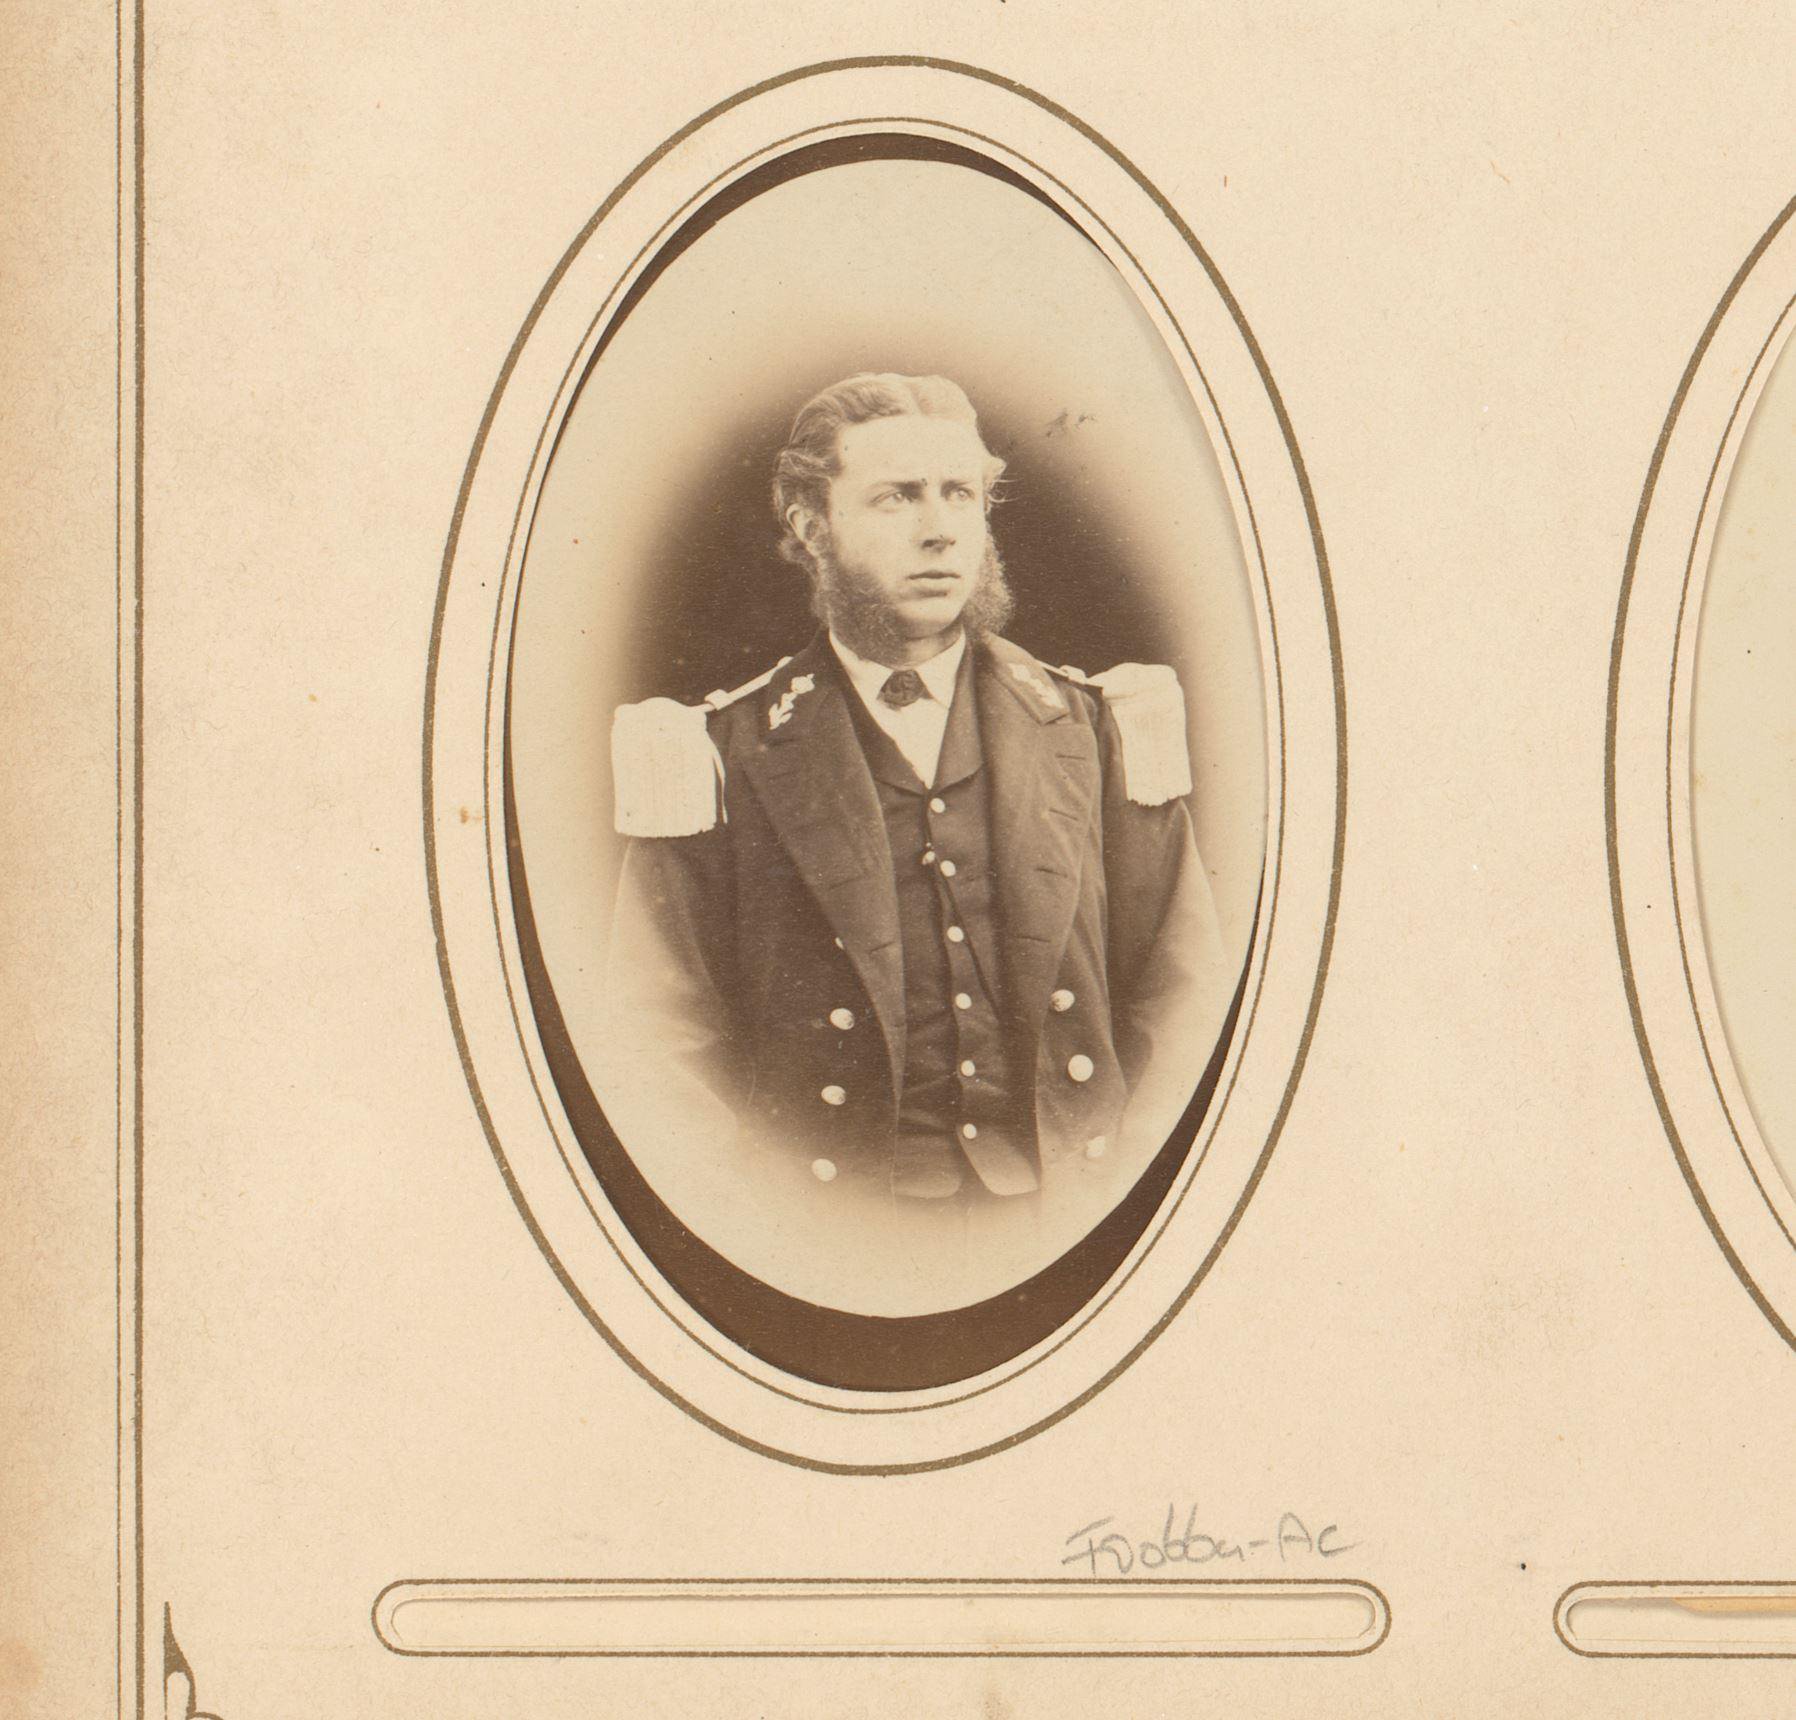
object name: album leaf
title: Portret van een man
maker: heinrich steinhauer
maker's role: fotograaf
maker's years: 1838-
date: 1869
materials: cardboard, photographic support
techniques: albumen print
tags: historical persons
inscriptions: annotation: ‘[Hillenoord]/ 1. November 1869/ Groeneyk’, inscription: ‘Photgraphie van H. Steinhauer/ Nieuwediep’